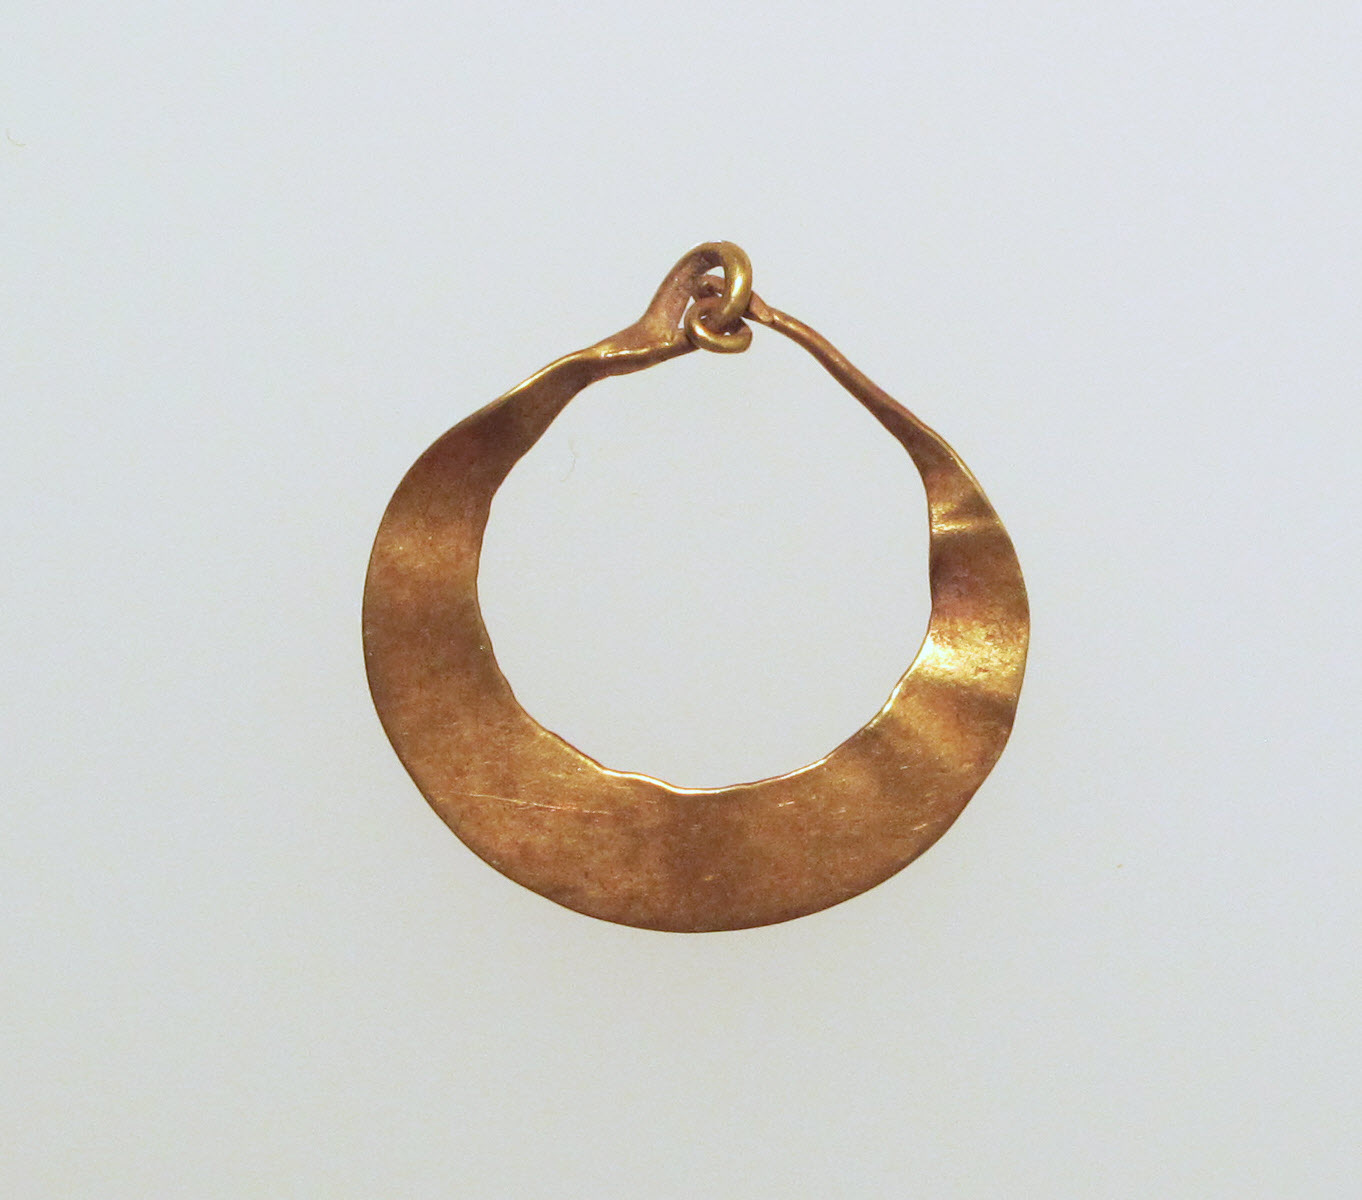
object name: earring, crescent shaped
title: Earring, crescent-shaped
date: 7000 BCE-330 CE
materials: gold